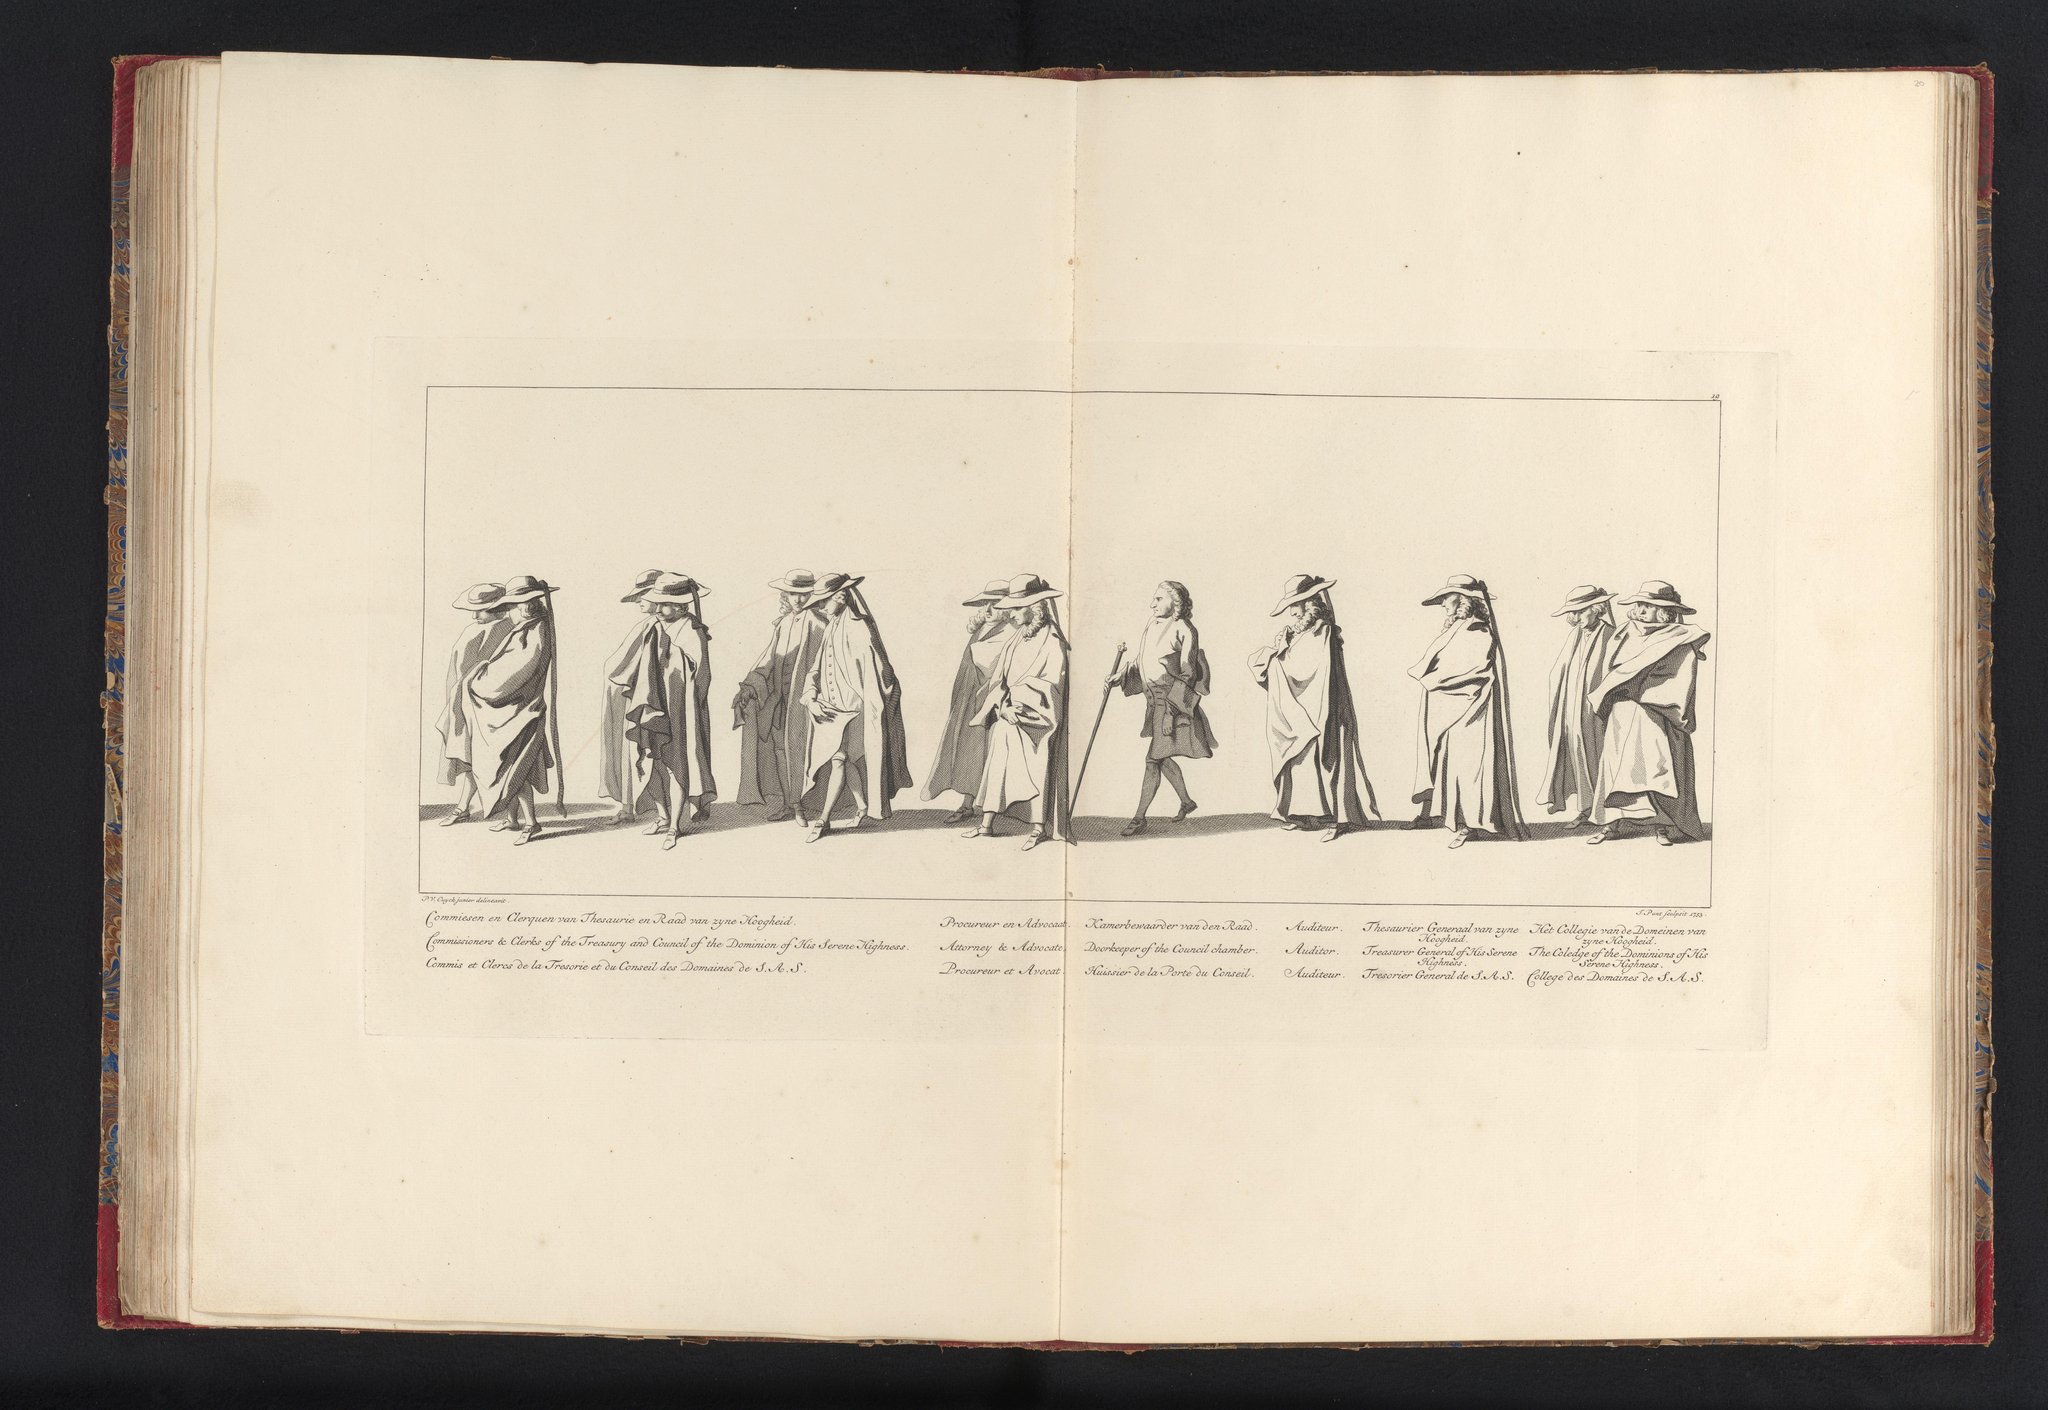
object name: album leaf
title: Lyk-staetsie van zyne doorluchtigste Hoogheid den Heere Willem Carel Hendrik Friso, Prince van Orange en Nassau (...) gehouden den IV Februari 1752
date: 1753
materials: paper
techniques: engraving, etching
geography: the hague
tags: the hague, willem iv (prins van oranje-nassau), cortege, funeral procession, royal household; courtiers, retinue, train, delft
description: Leden van het stadhouderlijk bestuurlijk apparaat. In de marge een onderschrift in het Nederlands, Frans en Engels. De prent maakt deel uit van een album.